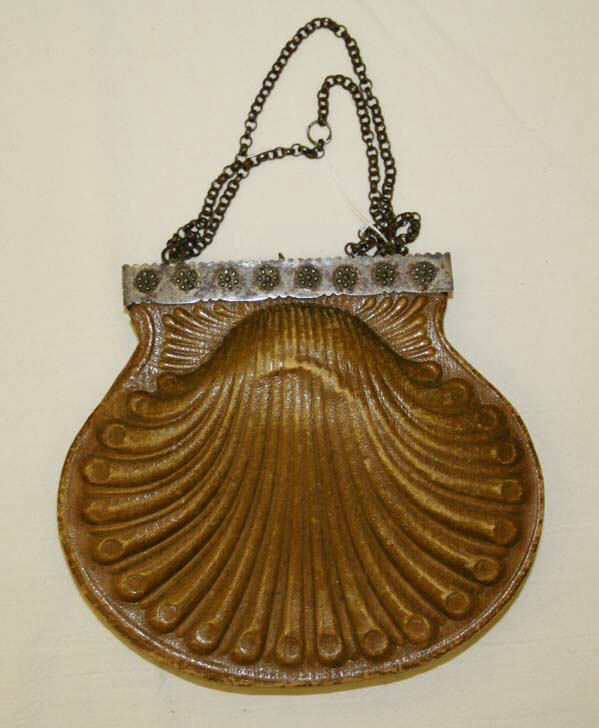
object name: purse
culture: american or european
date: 1824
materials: leather, paper, steel